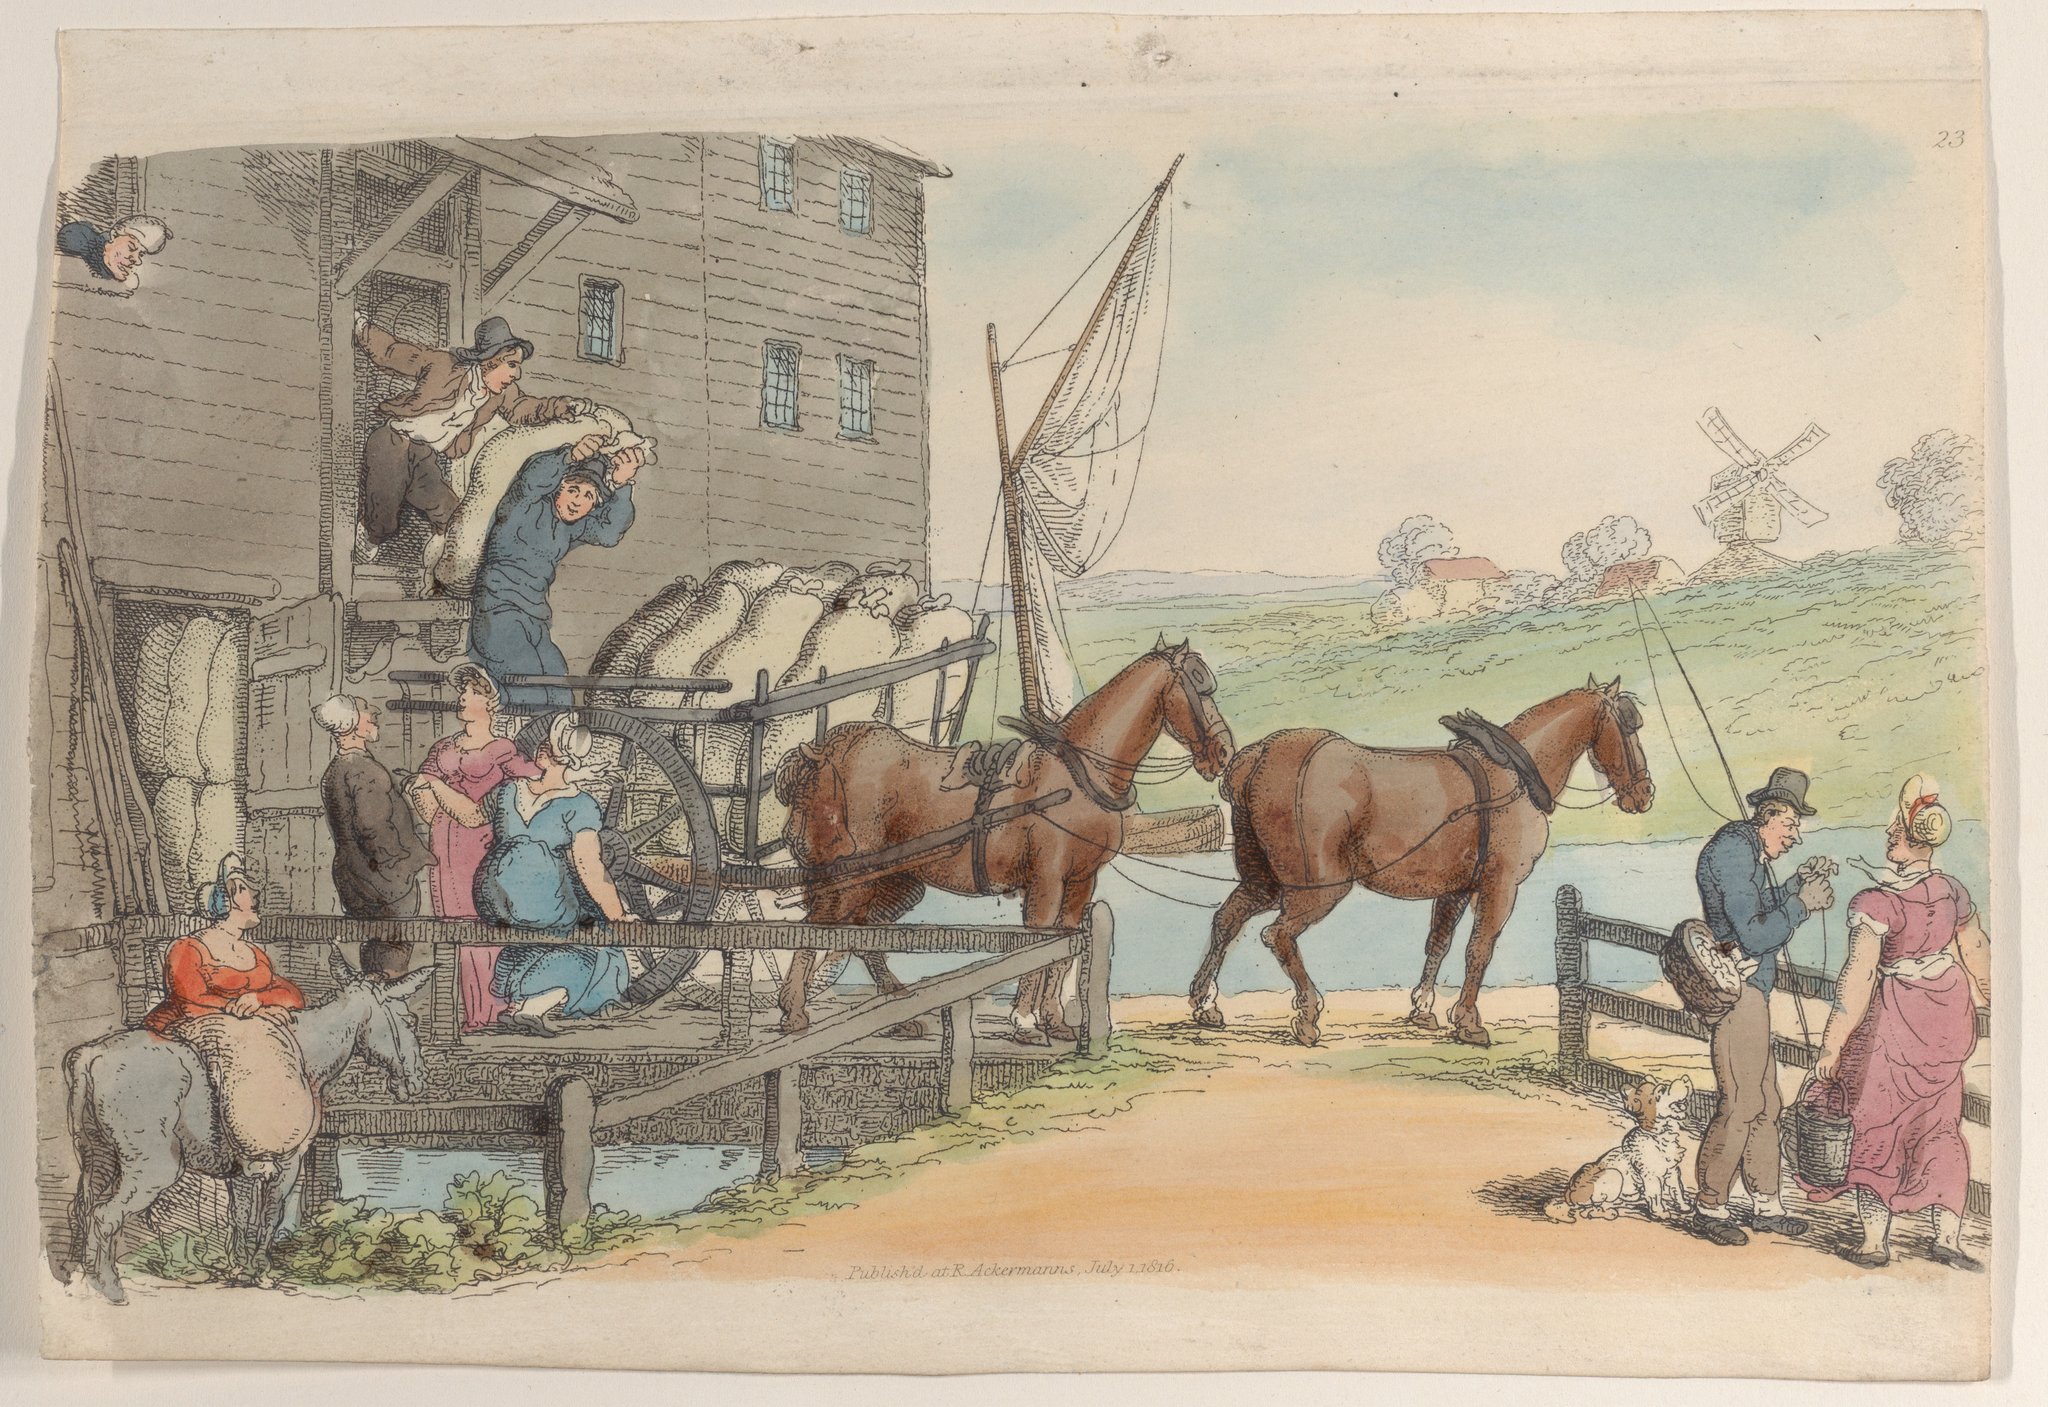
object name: print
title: Plate 23, from "World in Miniature"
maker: thomas rowlandson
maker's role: artist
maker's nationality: british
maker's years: 1757-1827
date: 1816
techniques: etching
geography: london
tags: men,women,dogs,horses,carts